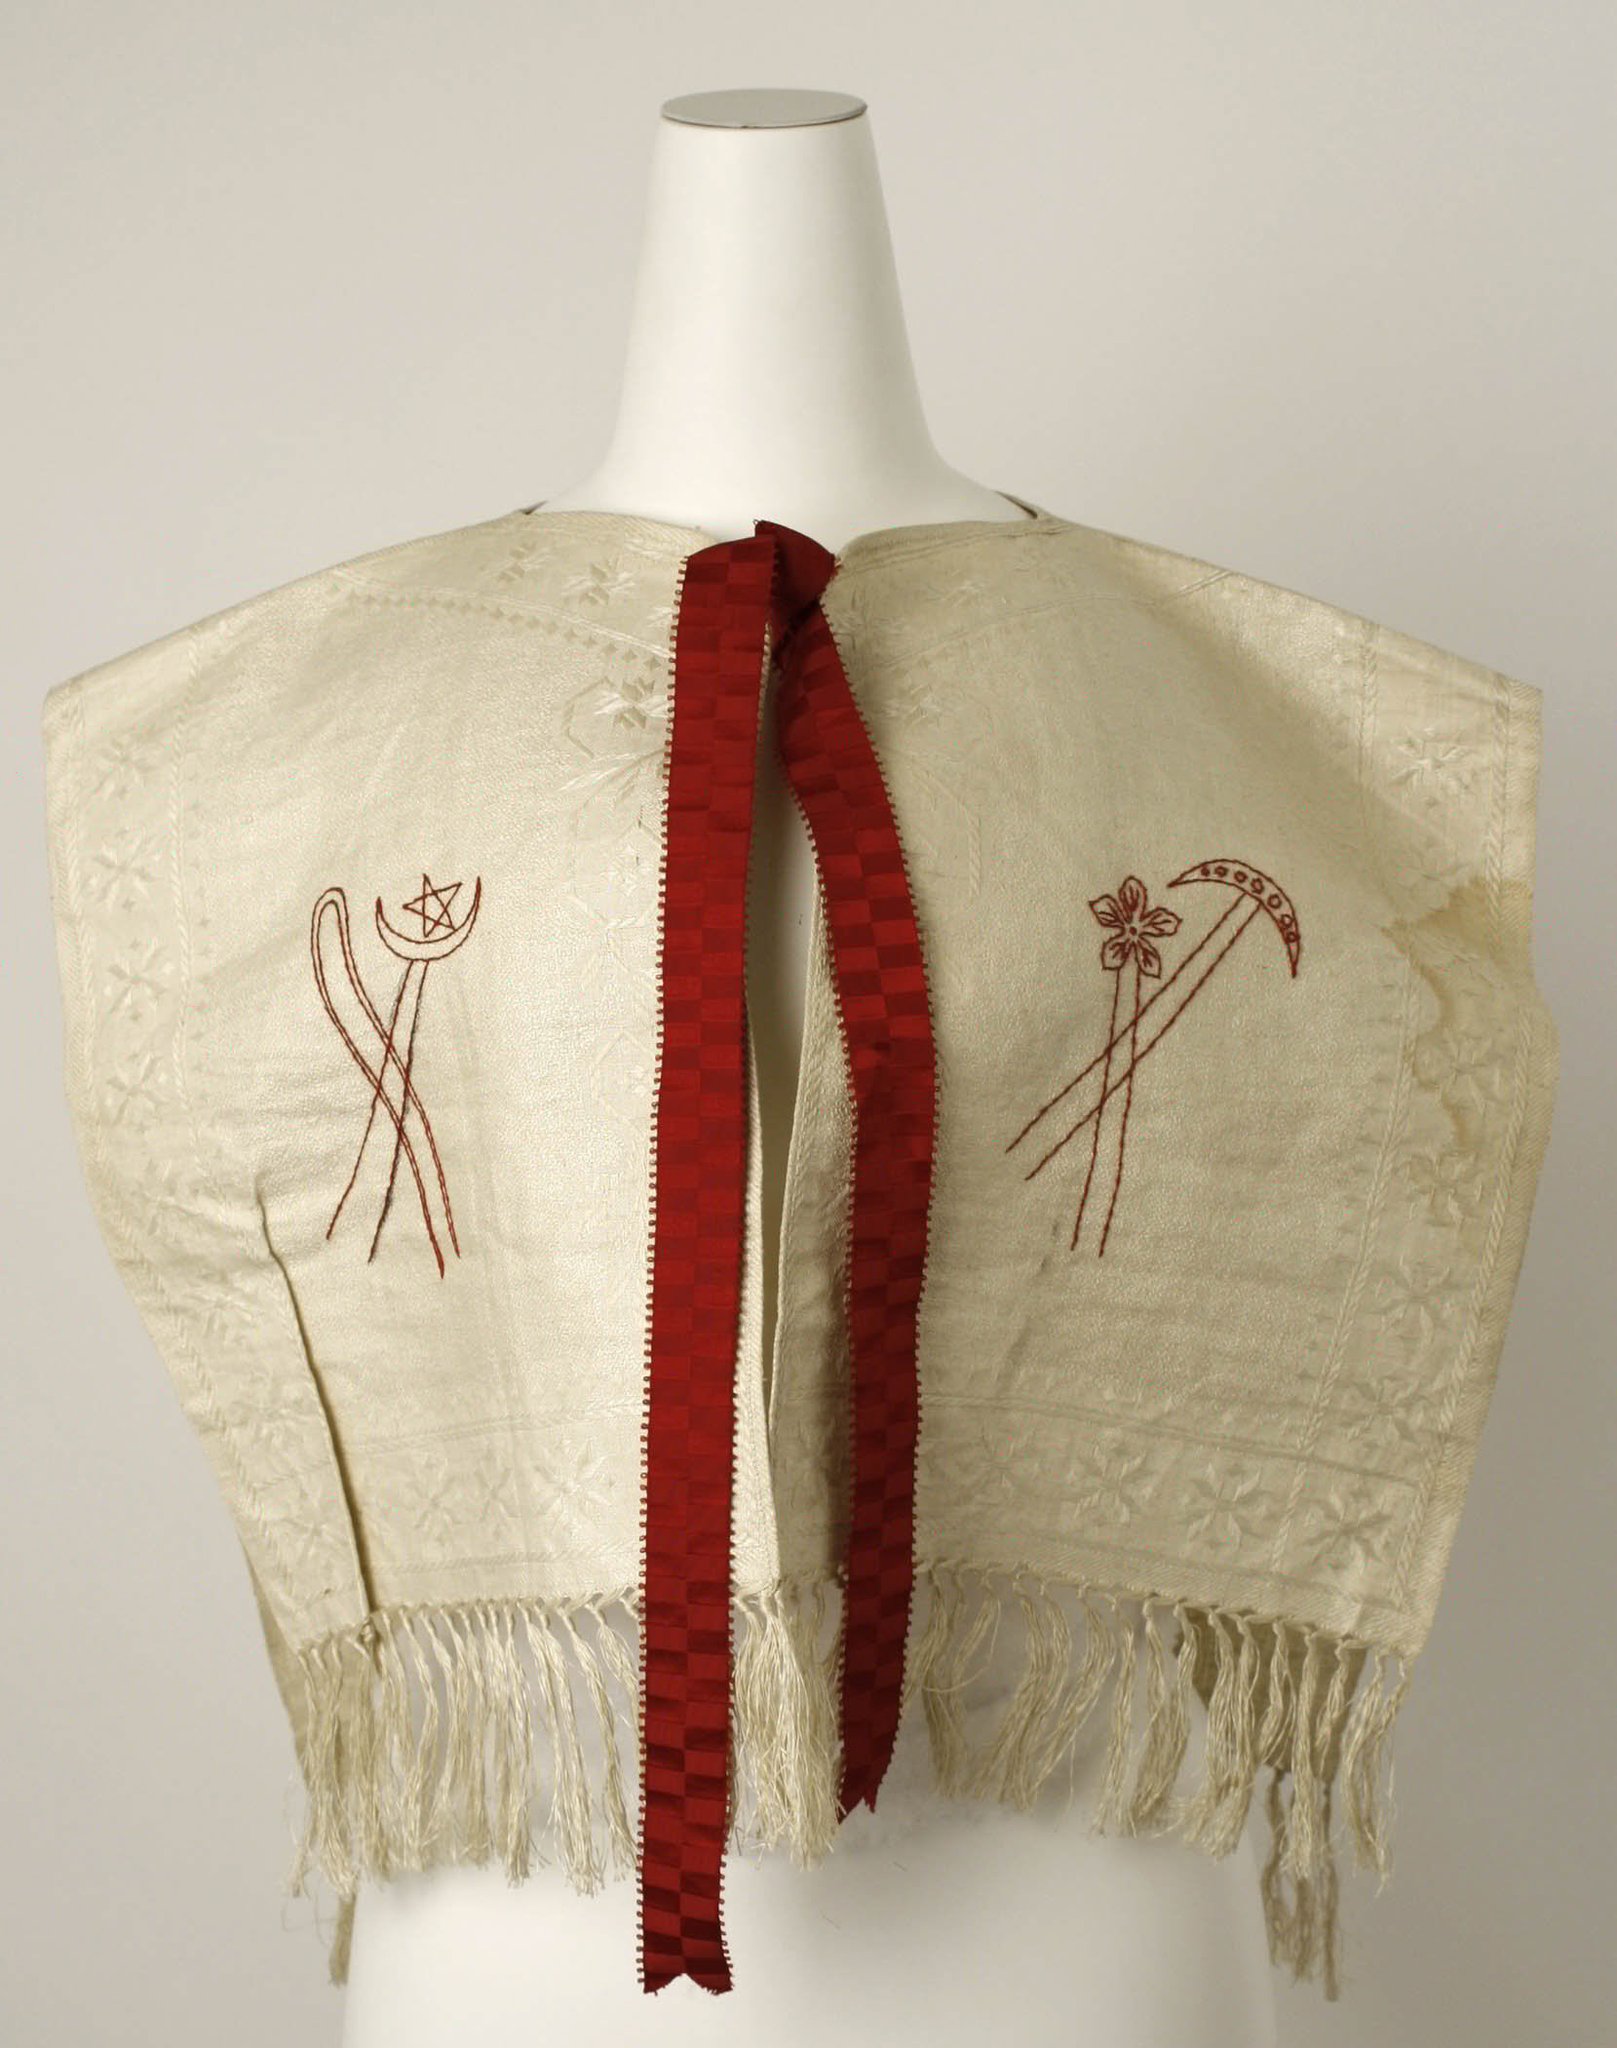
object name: bib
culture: american or european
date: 1880-1890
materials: linen, silk